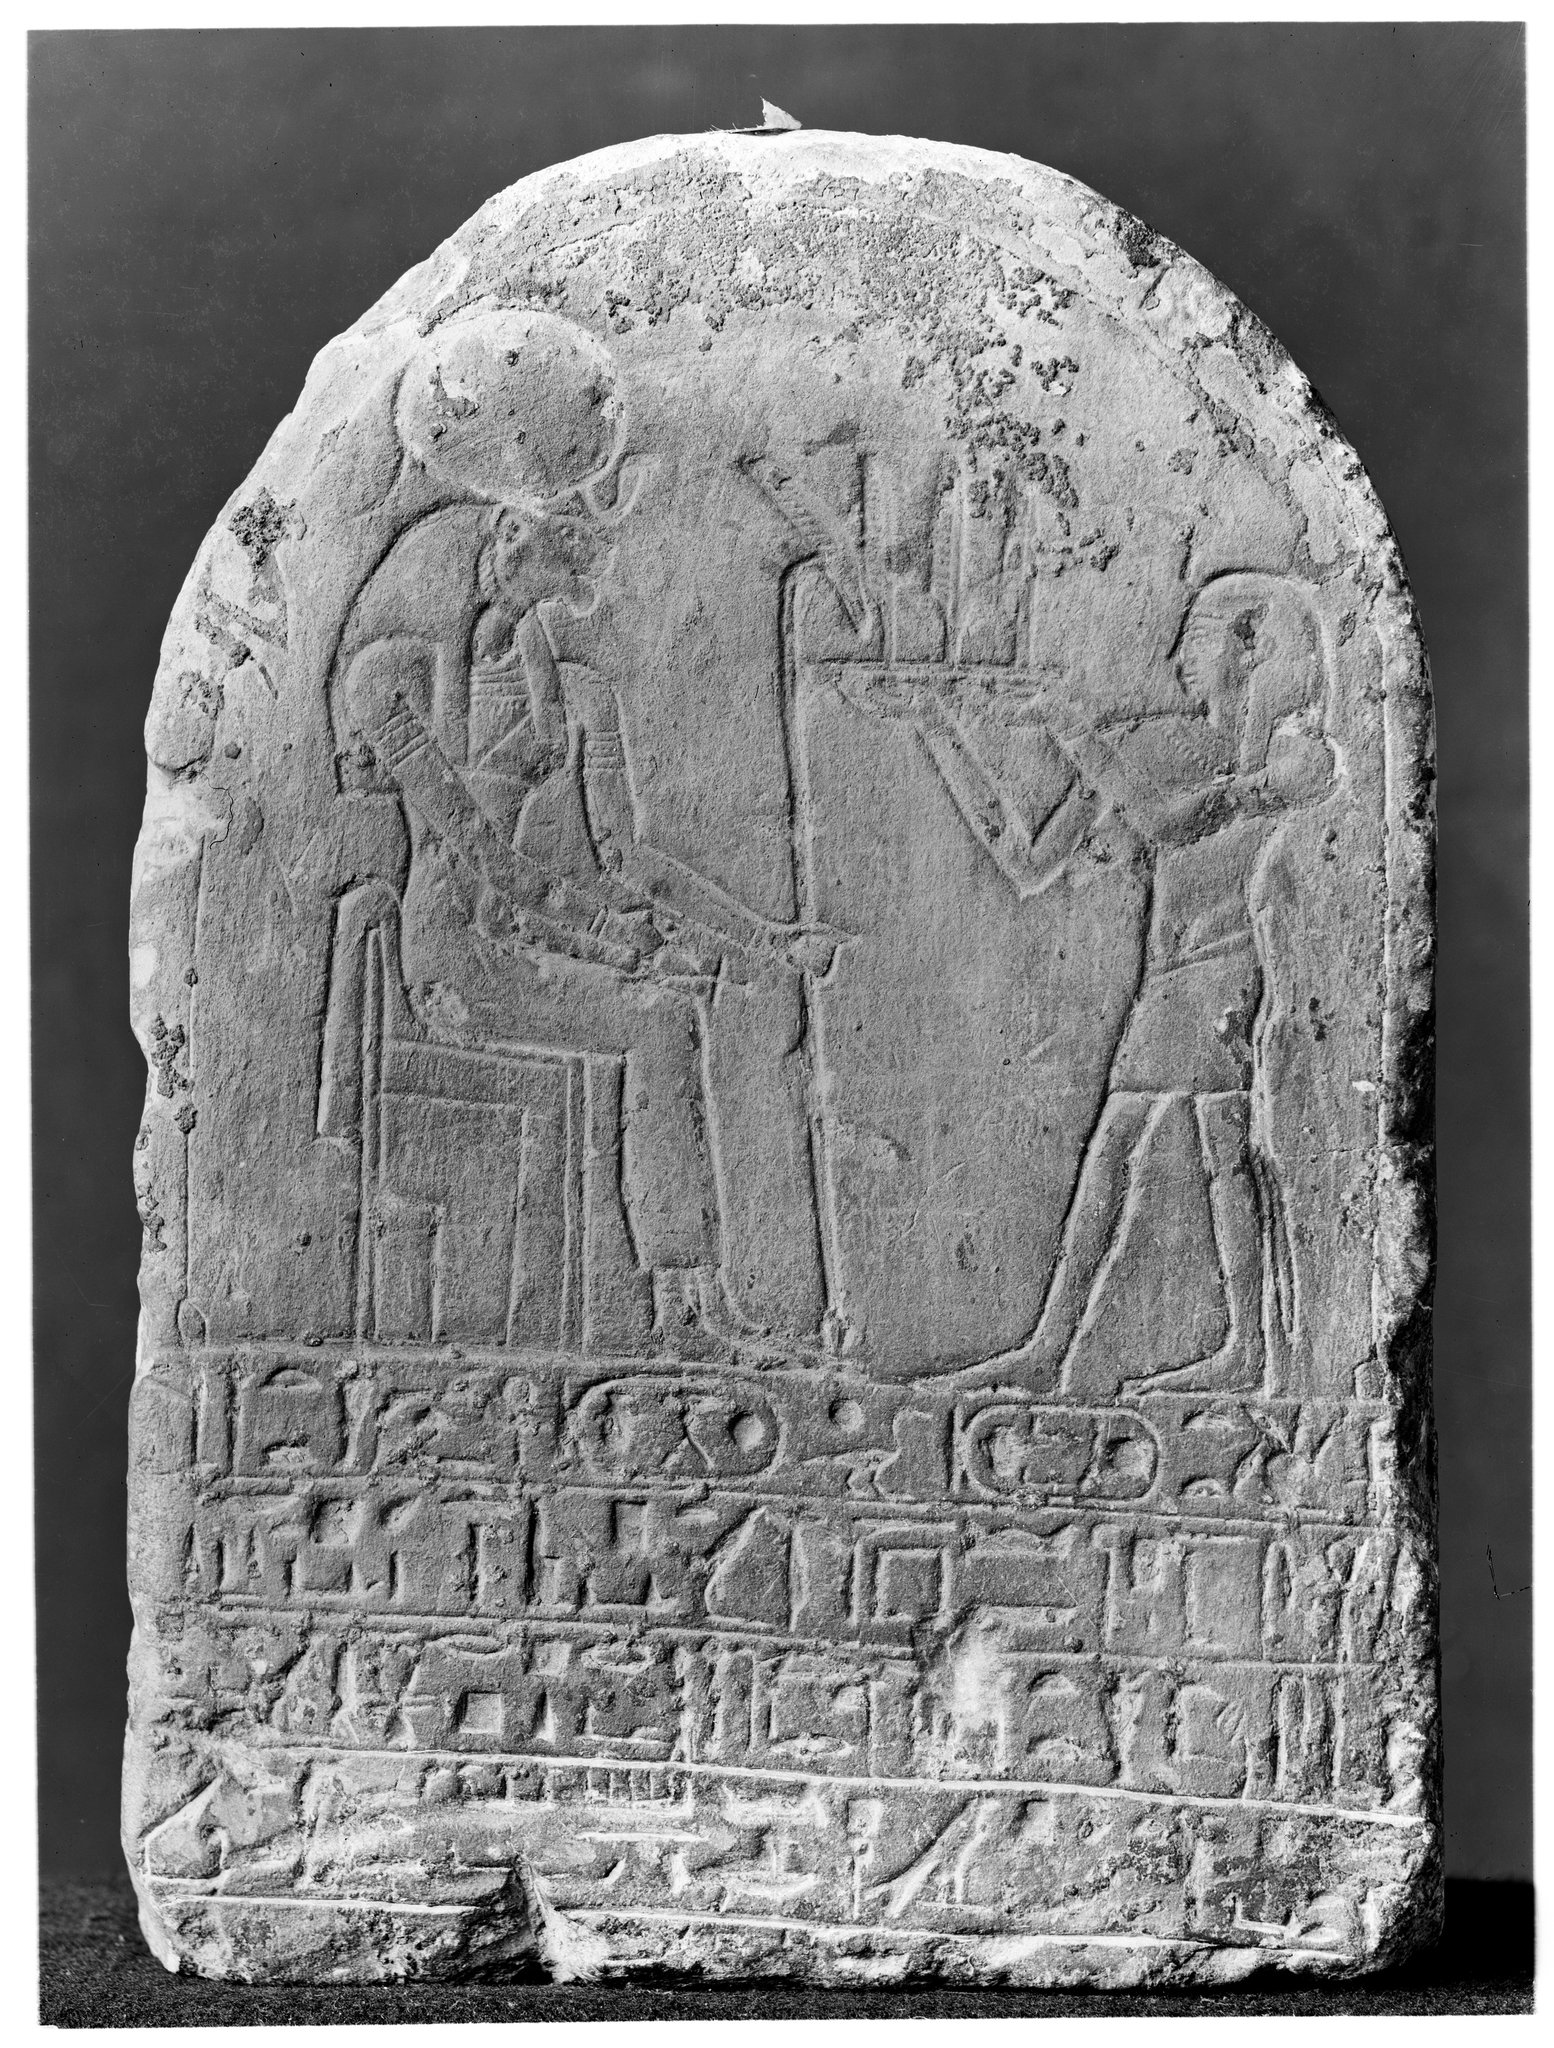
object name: stela, bastet, apries, donation stela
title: Donation stela: Apries offers land to Bastet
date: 589-570 BCE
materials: limestone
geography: egypt